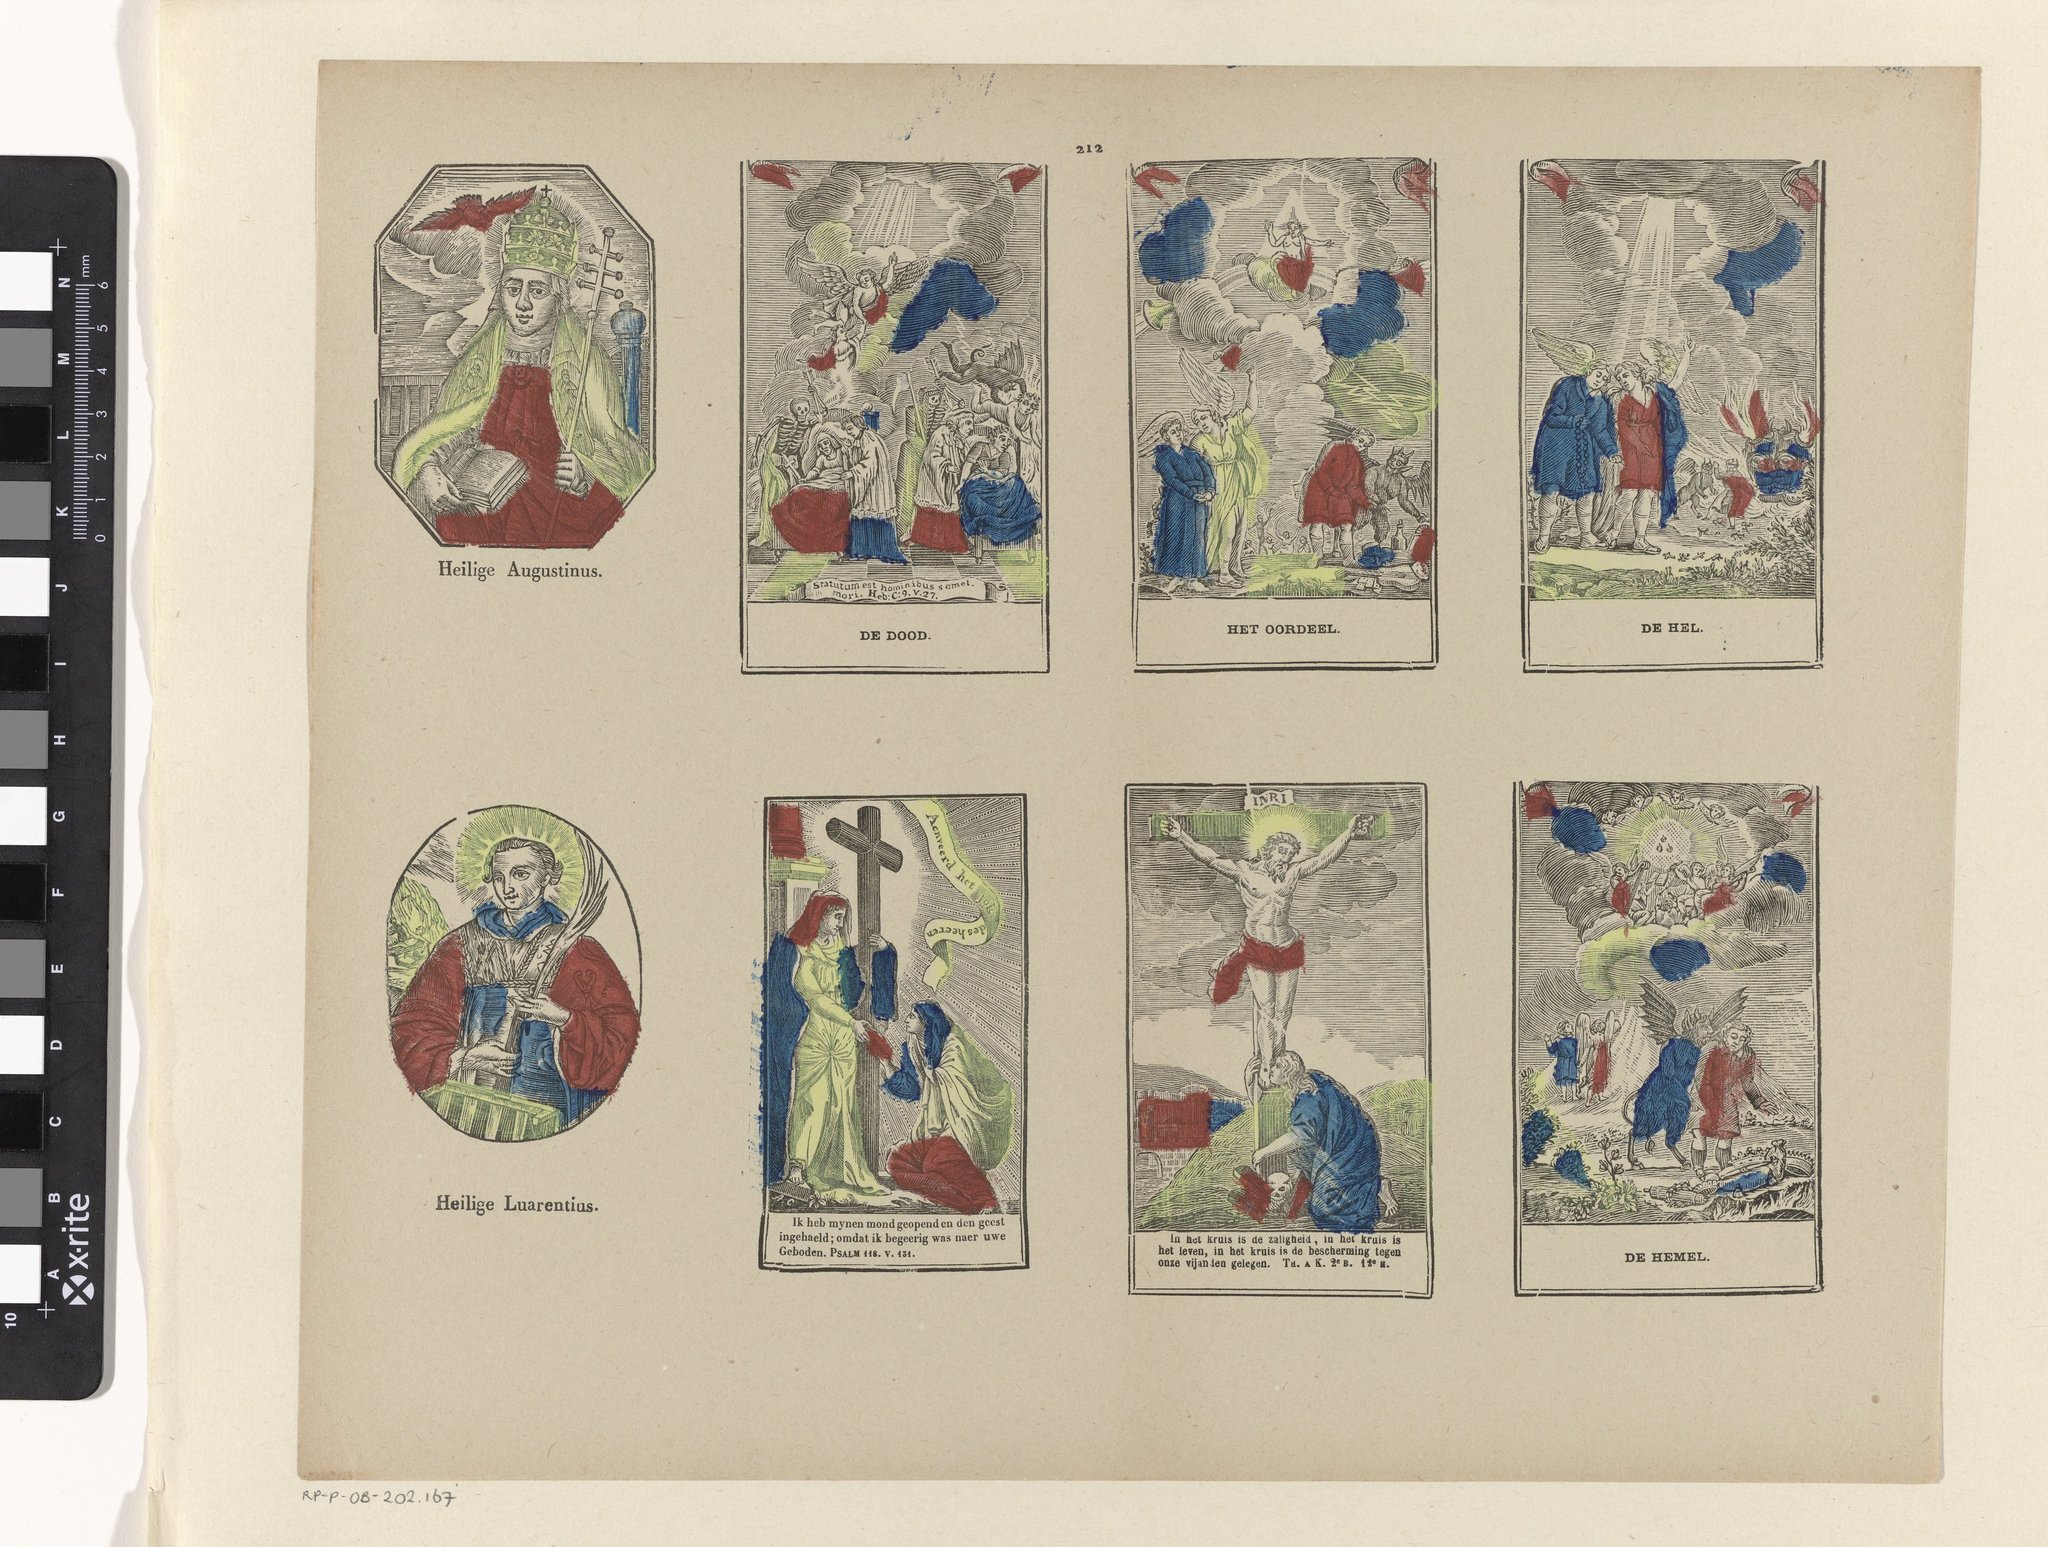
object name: popular print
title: Religieuze voorstellingen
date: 1800-1833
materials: paper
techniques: colour, letterpress printing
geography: turnhout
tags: augustine, bishop of hippo; possible attributes: arrows piercing his breast, book, child with spoon, flaming heart, heart (pierced with arrows), pen, crucified christ with mary magdalene, who usually weeps and embraces the cross - dd - the three crosses, last judgement, the martyr and deacon laurence of rome; possible attributes: book, censer, cross, dalmatic, gridiron, palm, purse (or cup with golden coins), pope gregory the great; possible attributes: dove, emperor trajan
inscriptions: collector's mark: Lugt 2760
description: Blad met 8 religieuze voorstellingen, waaronder de heilige Gregorius (foutief vermeldt als Augustinus) en Laurentius, het Laatste Oordeel en Christus aan het kruis. Onder elke voorstelling een onderschrift. Genummerd midden boven: 212.